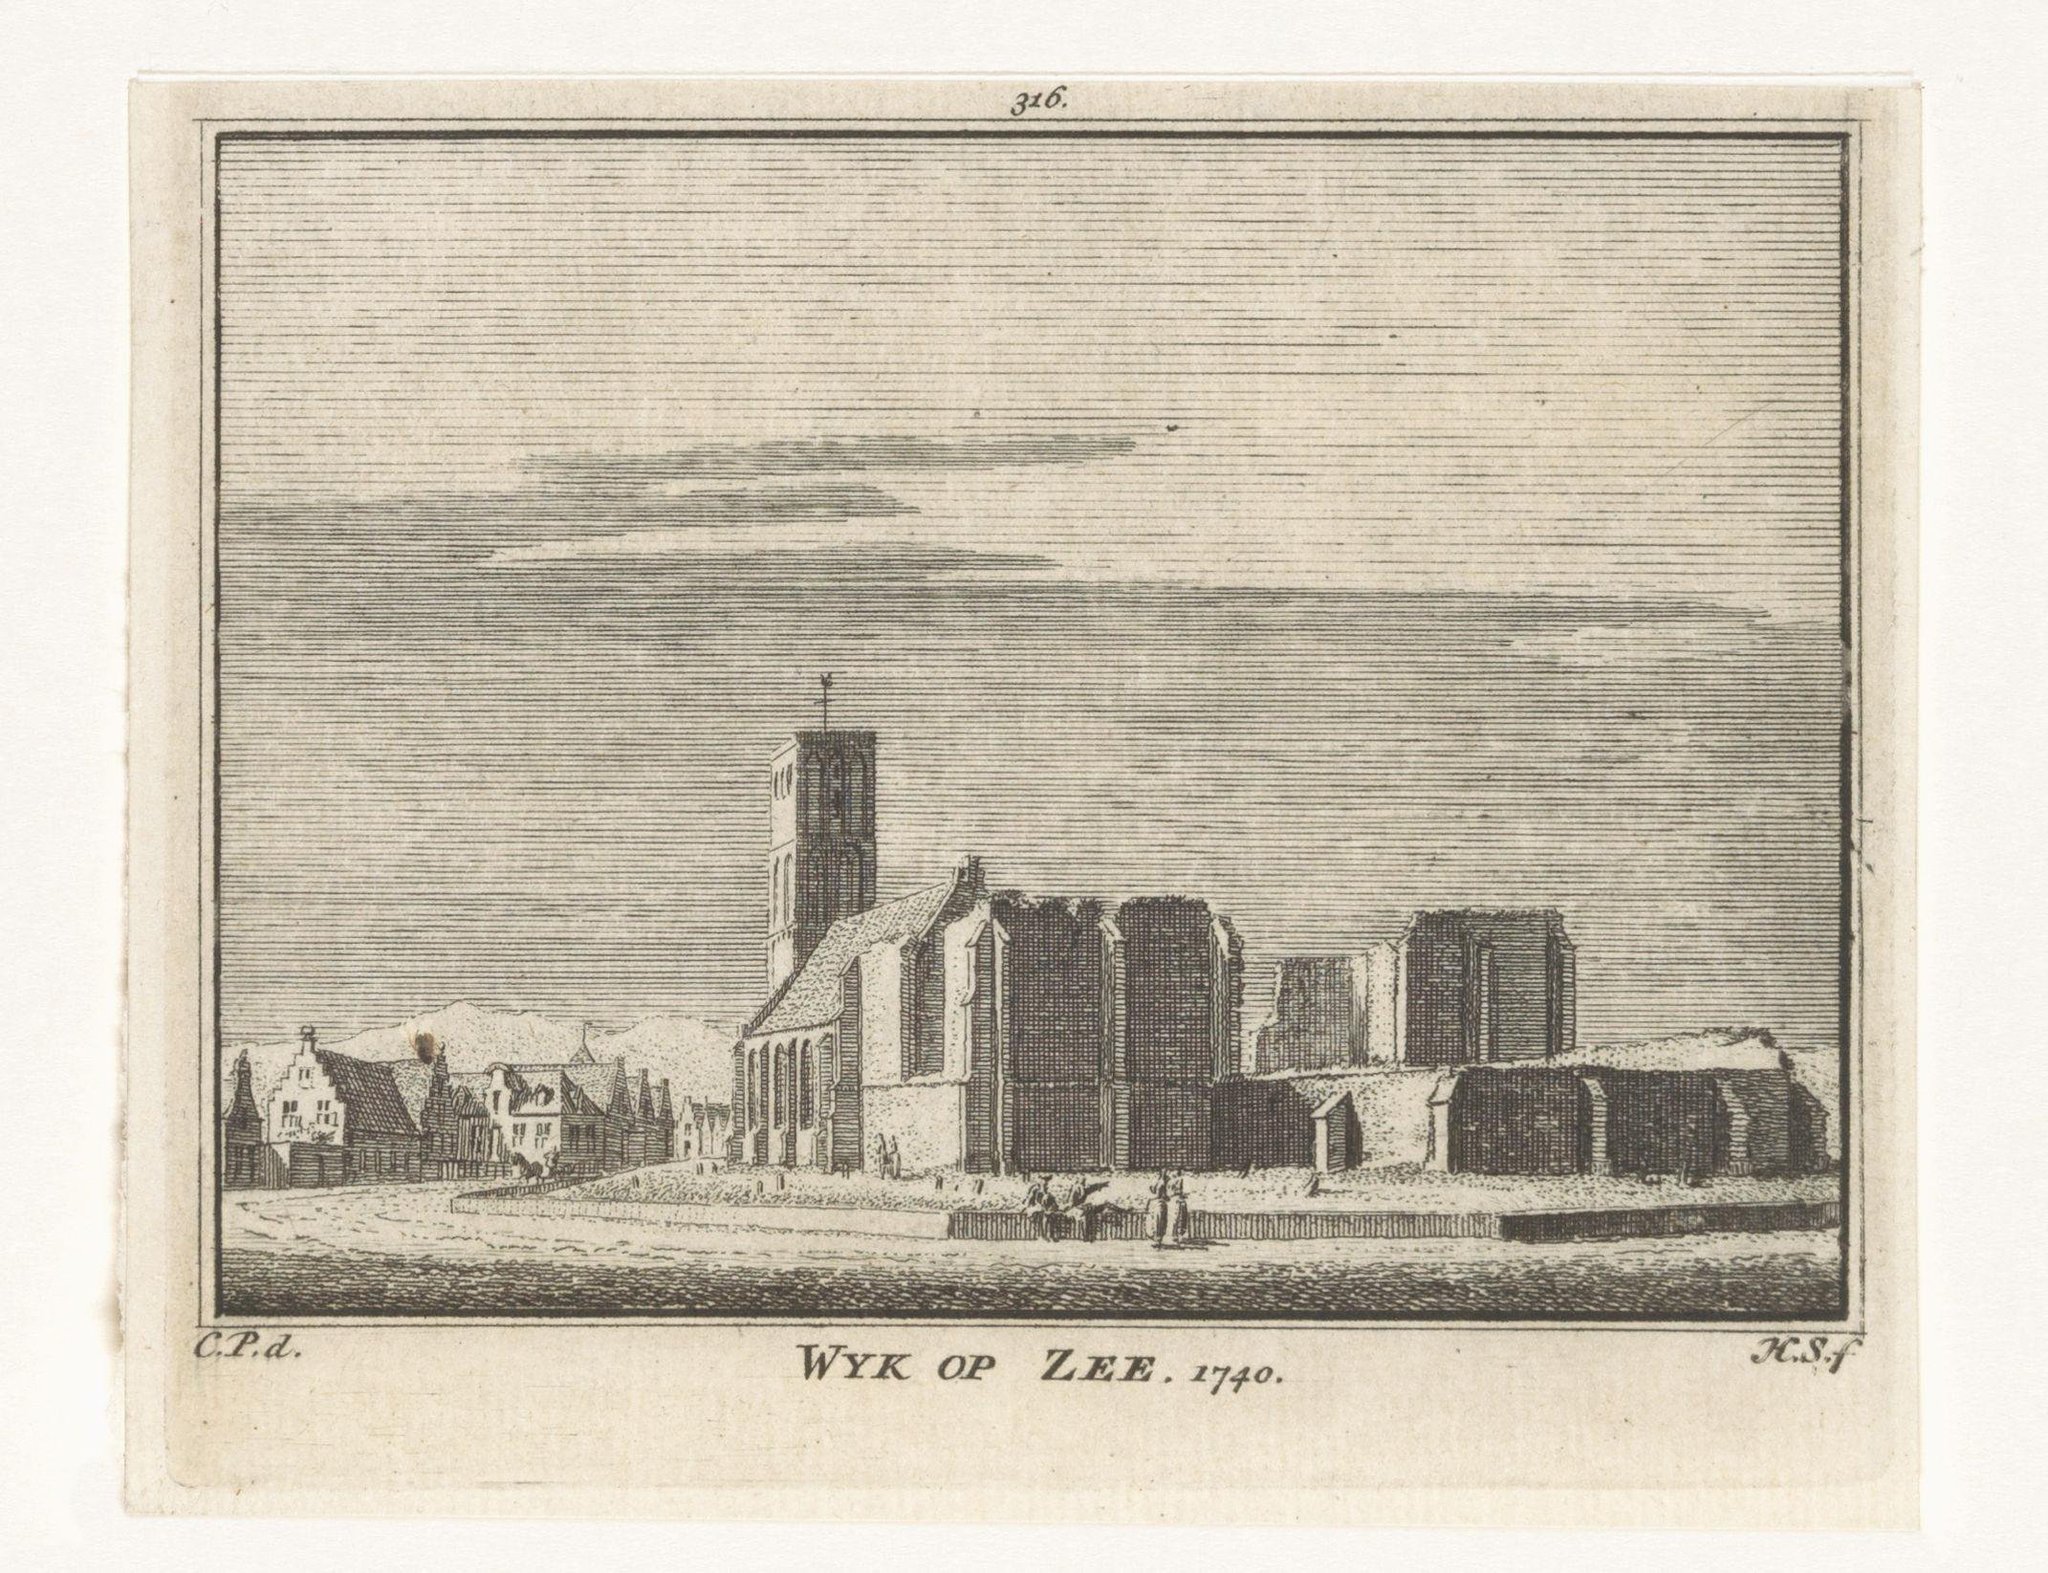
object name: book illustration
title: Gezicht op Wijk aan Zee, 1740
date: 1752-1792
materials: paper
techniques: engraving, etching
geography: haarlem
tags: prospect of village, silhouette of village, church (exterior)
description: Prent ook gebruikt in: Het verheerlykt Nederland of kabinet van hedendaagsche gezigten van steden, dorpen (…). 9 delen. Amsterdam: Isaak Tirion en weduwe Isaak Tirion, 1745-1774, dl. 4 (1752), ill. 316. Of in: Nederlandsche tafereelen; of eene keurige verzameling van negen honderd fraaije gezigten van steden, dorpen, sloten, oudheden (….). 9 delen. Amsterdam: Jan de Groot, 1792, dl. 4, ill. 316. Uit welke druk het huidige exemplaar precies komt is niet na te gaan.